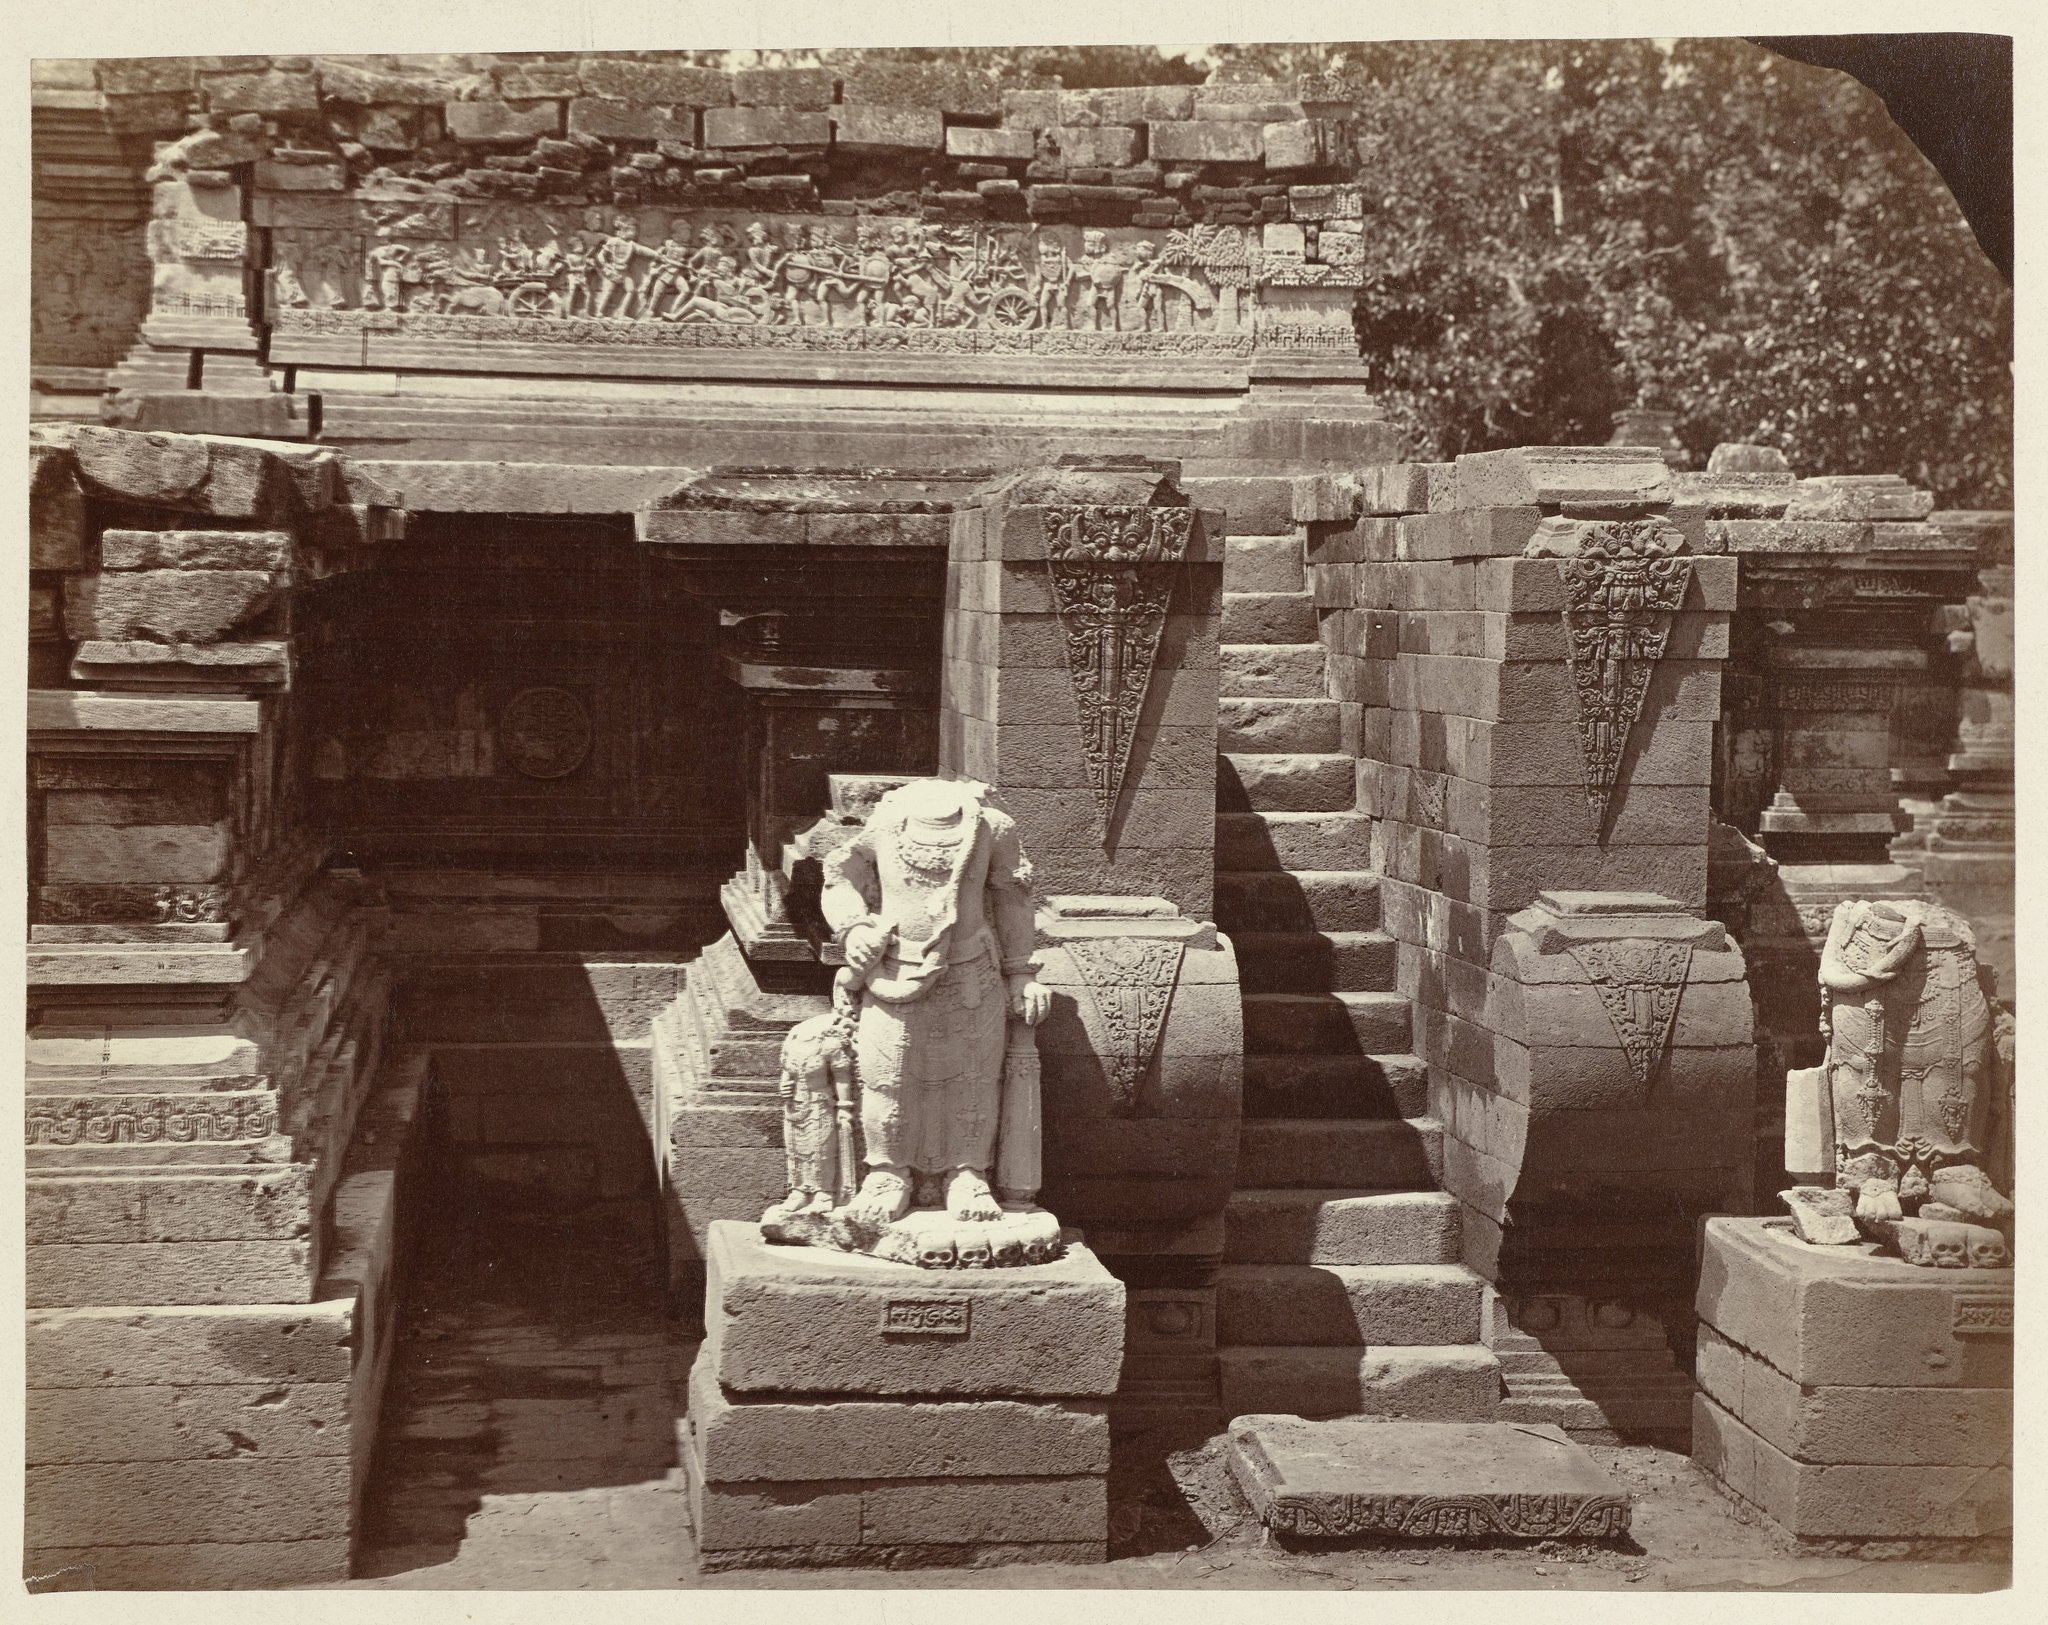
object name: photograph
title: De trap van de Candi Panataran gezien vanaf de westzijde.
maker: isidore kinsbergen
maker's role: fotograaf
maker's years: 1821-1905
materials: cardboard, paper, photographic support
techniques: albumen print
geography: java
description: Candi Panataran (Temple Complex), main Temple; headless guardian figures (dvaraoakas) close to the right staircase, west side. Panataran, Blitar district, East Java province 1323-1347 AD.